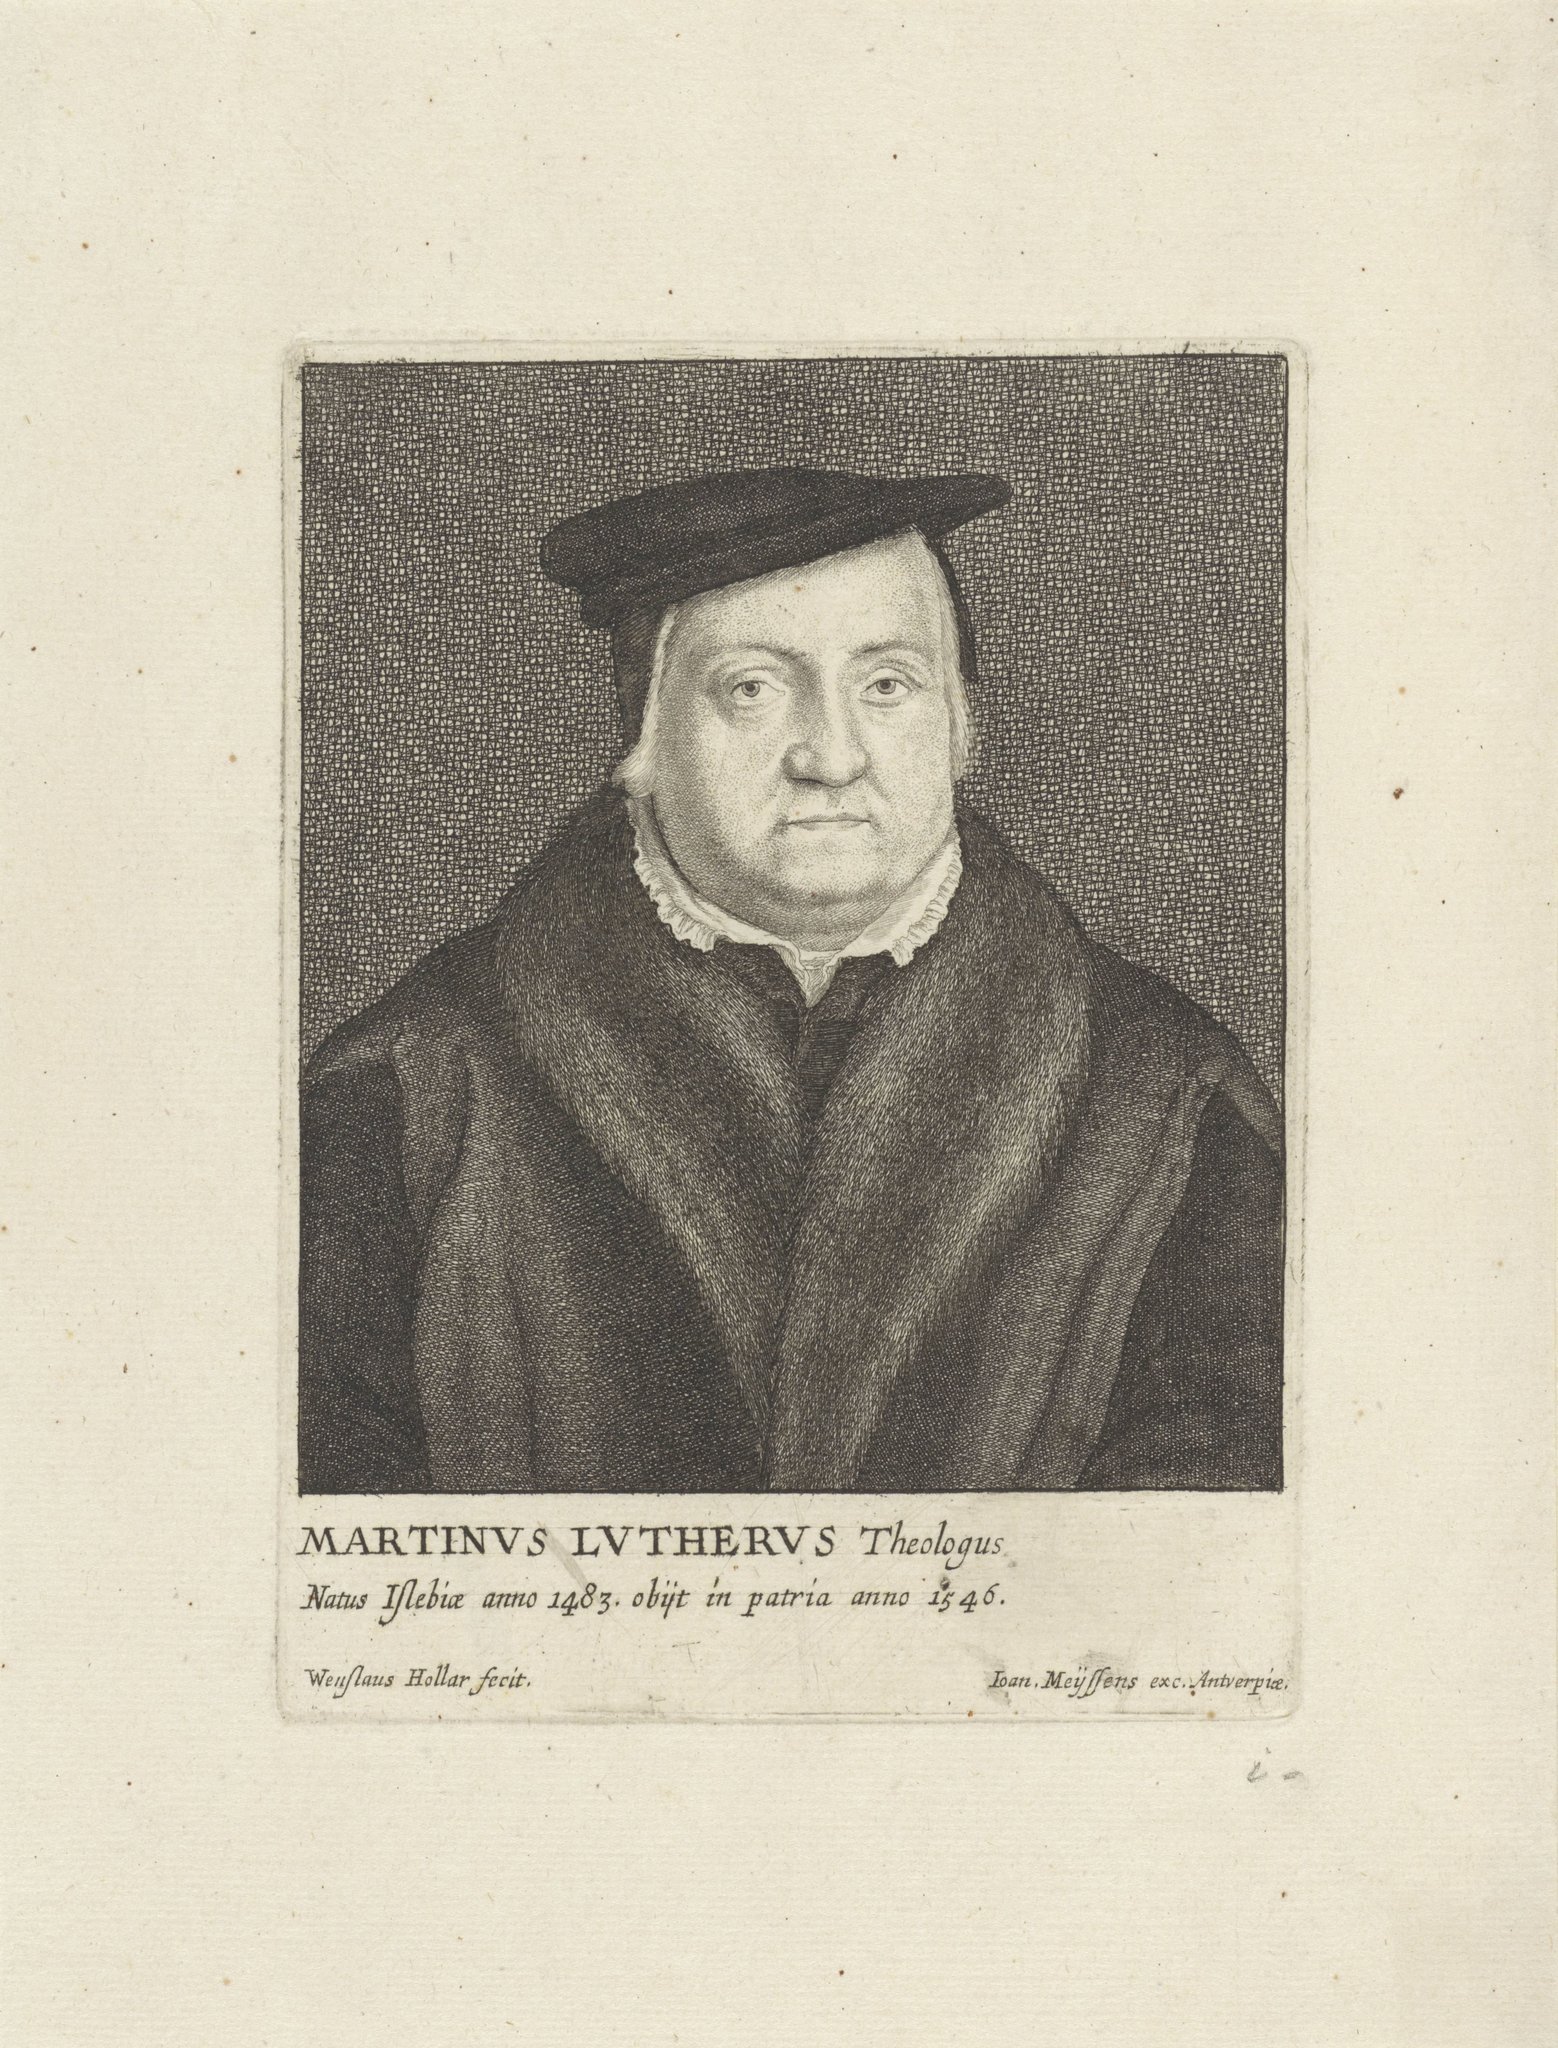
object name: print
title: Portret van een man met baret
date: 1640-1670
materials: paper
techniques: etching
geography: antwerp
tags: priest, martin luther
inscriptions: collector's mark: Lugt 2228